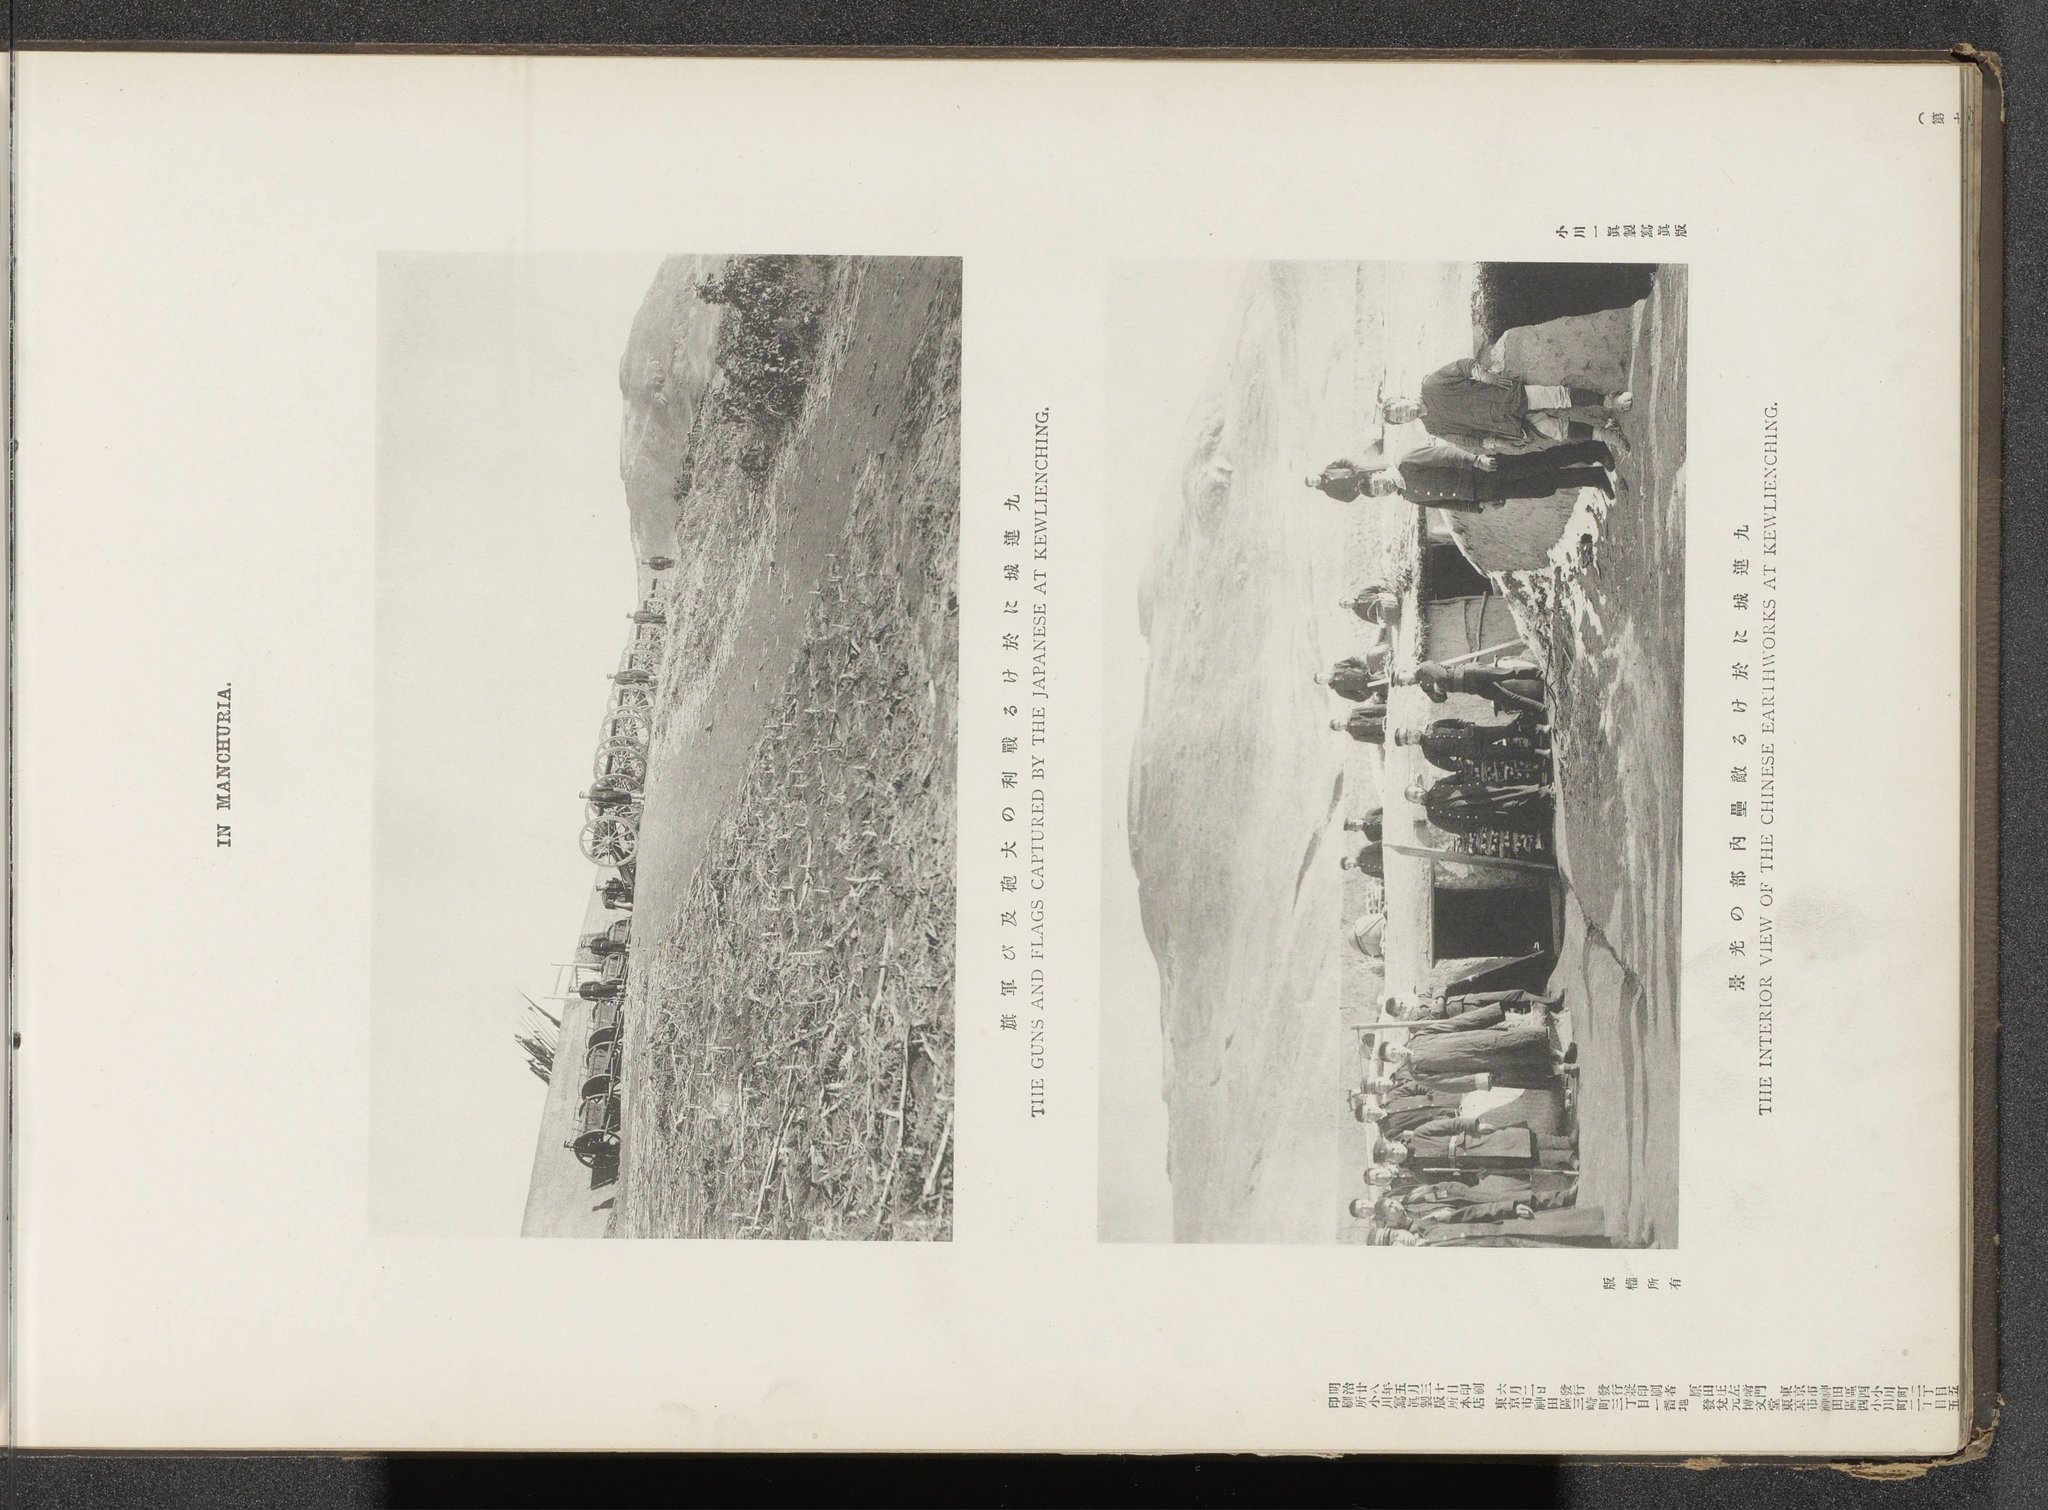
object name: photomechanical print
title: The guns and flags captured by the Japanese at Kewlienching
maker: kazumasa ogawa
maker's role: auteur, fotograaf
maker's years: 1860-1929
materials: paper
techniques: photograph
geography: japan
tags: warfare; military affairs, booty, spoil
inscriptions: inscription: ‘In Manchuria.’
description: Boven de buitgemaakte vlaggen door het Japanse leger, onder het Chinese grondverzet te Kewlienching.